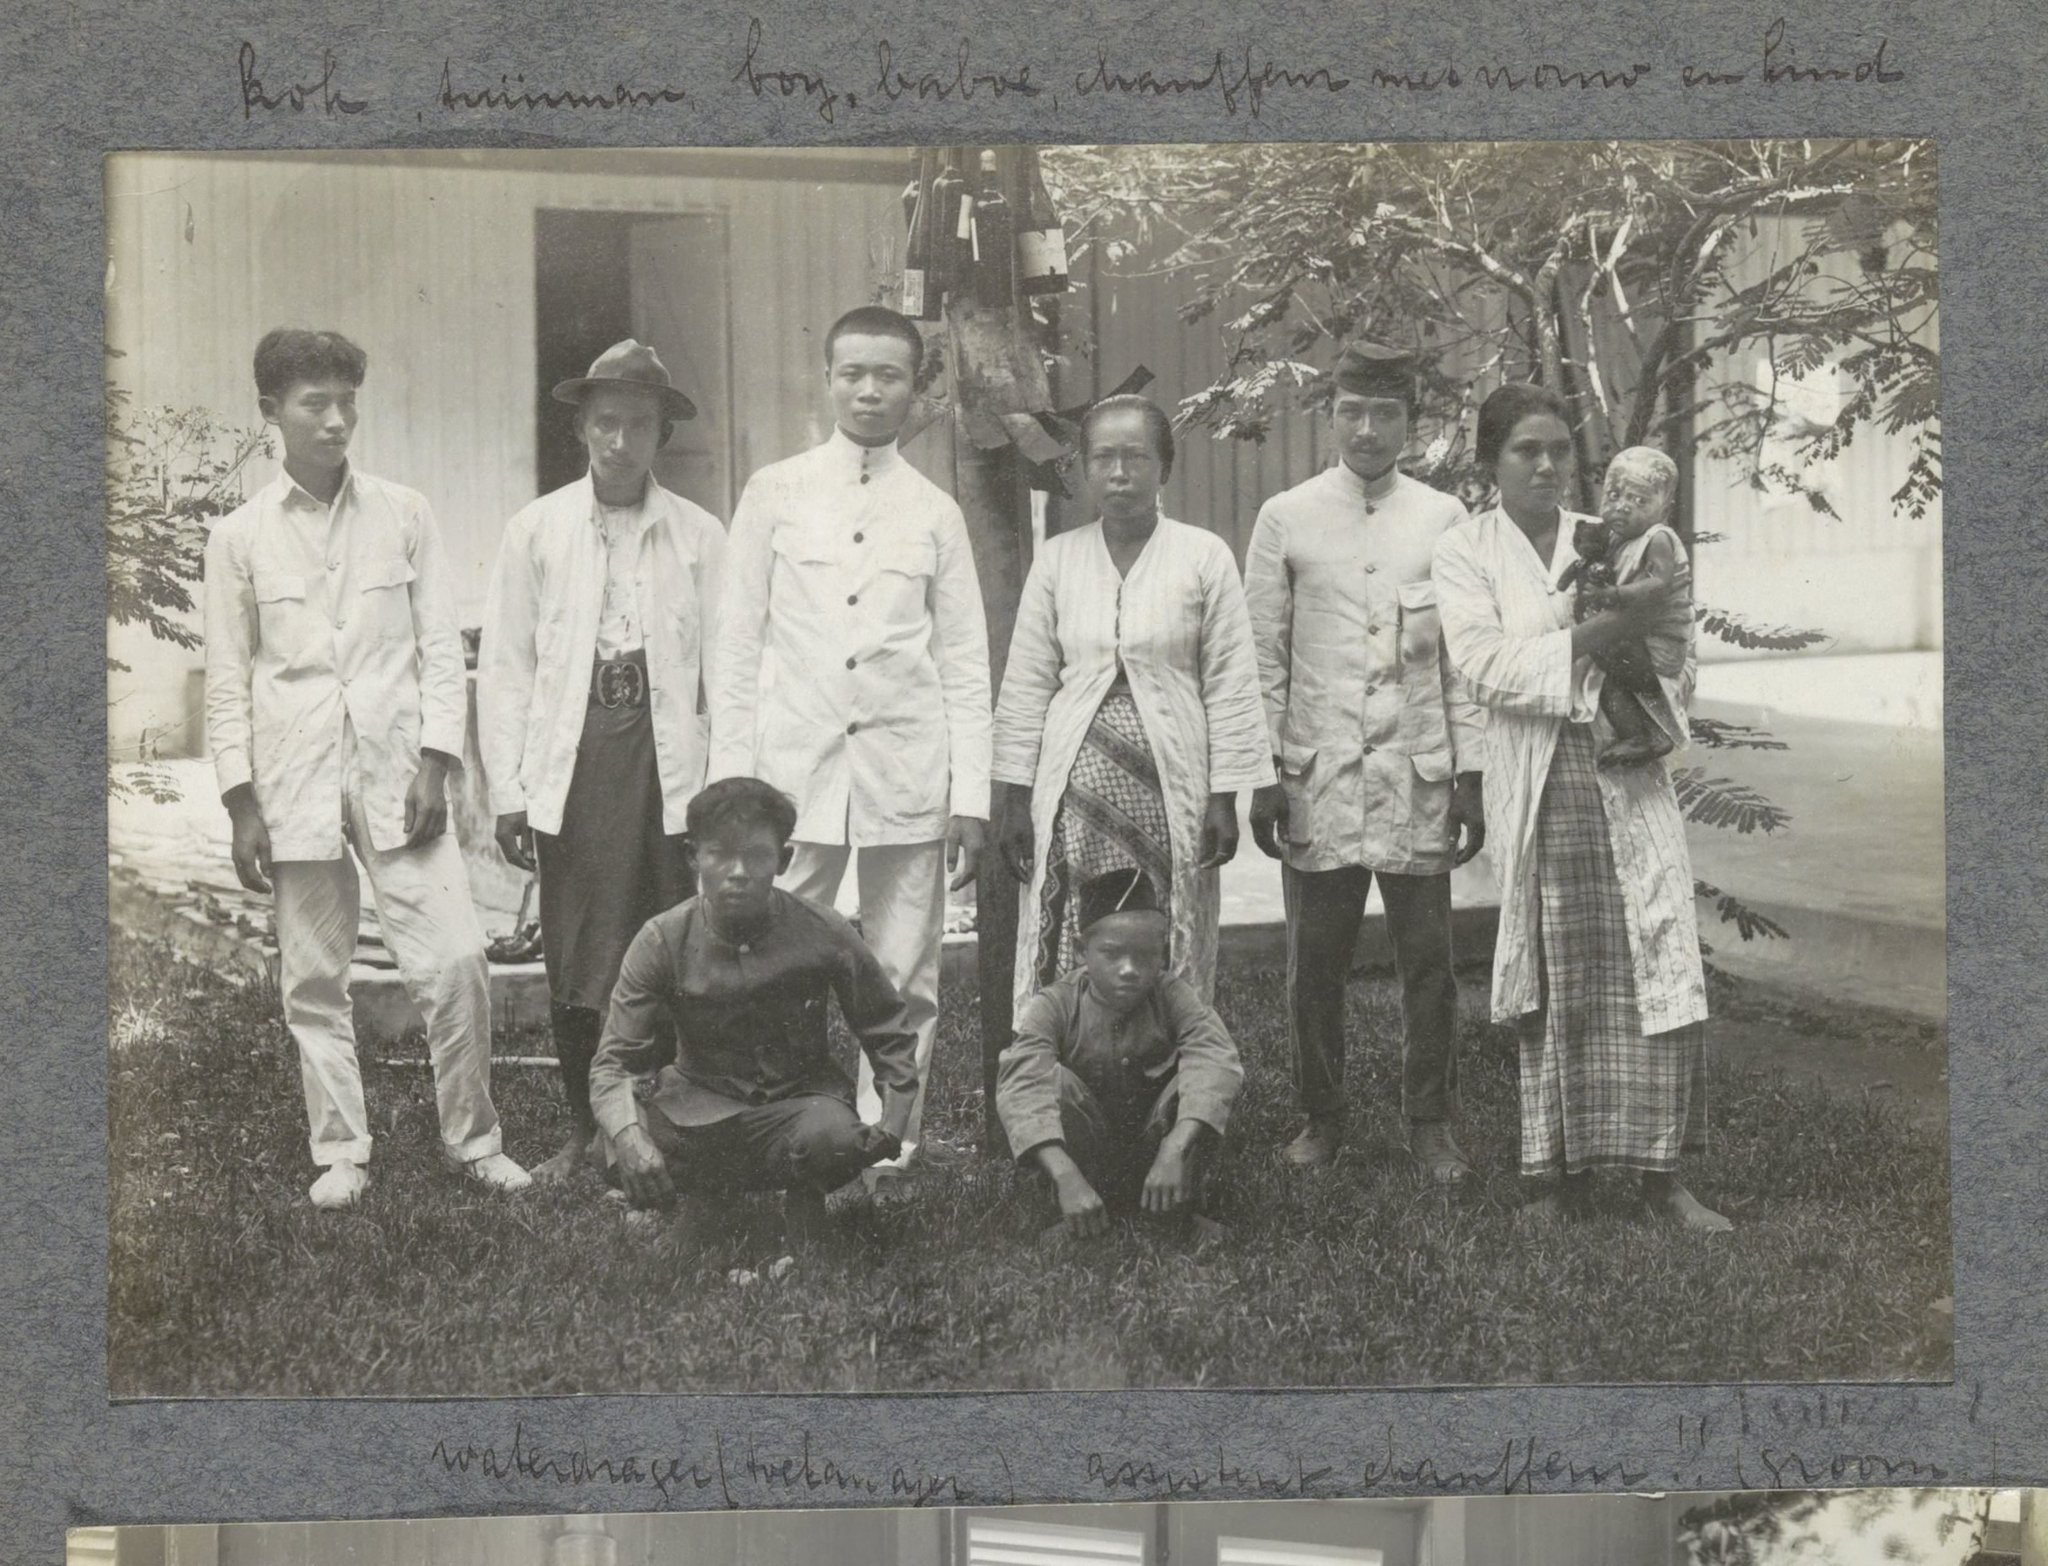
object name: photograph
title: Groepsfoto van Indisch personeel in een tuin op Sumatra: de kok, de tuinman, de boy, de baboe, de chauffeur en de waterdrager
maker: Anonymous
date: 1914-1926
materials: photographic support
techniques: gelatin silver print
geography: sumatra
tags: baby-sitter, skin and venereal diseases, mother and baby or young child, house personnel, servants, sumatra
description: Staand van links naar rechts: de kok, timmerman, huisbediende (aangeduid als ‘boy’), kinderverzorgster (aangeduid als ‘baboe’), chauffeur met zijn vrouw in kind. Gehurkt van links naar rechts: de waterdrager (aangeduid als ‘toekan ajer’) en assistent-chauffeur. Gemaakt in de tuin. Onderdeel van Fotoalbum met opnames van de familie Bergsma in Tandjong Poera en Rantan Pandjang (Sumatra).